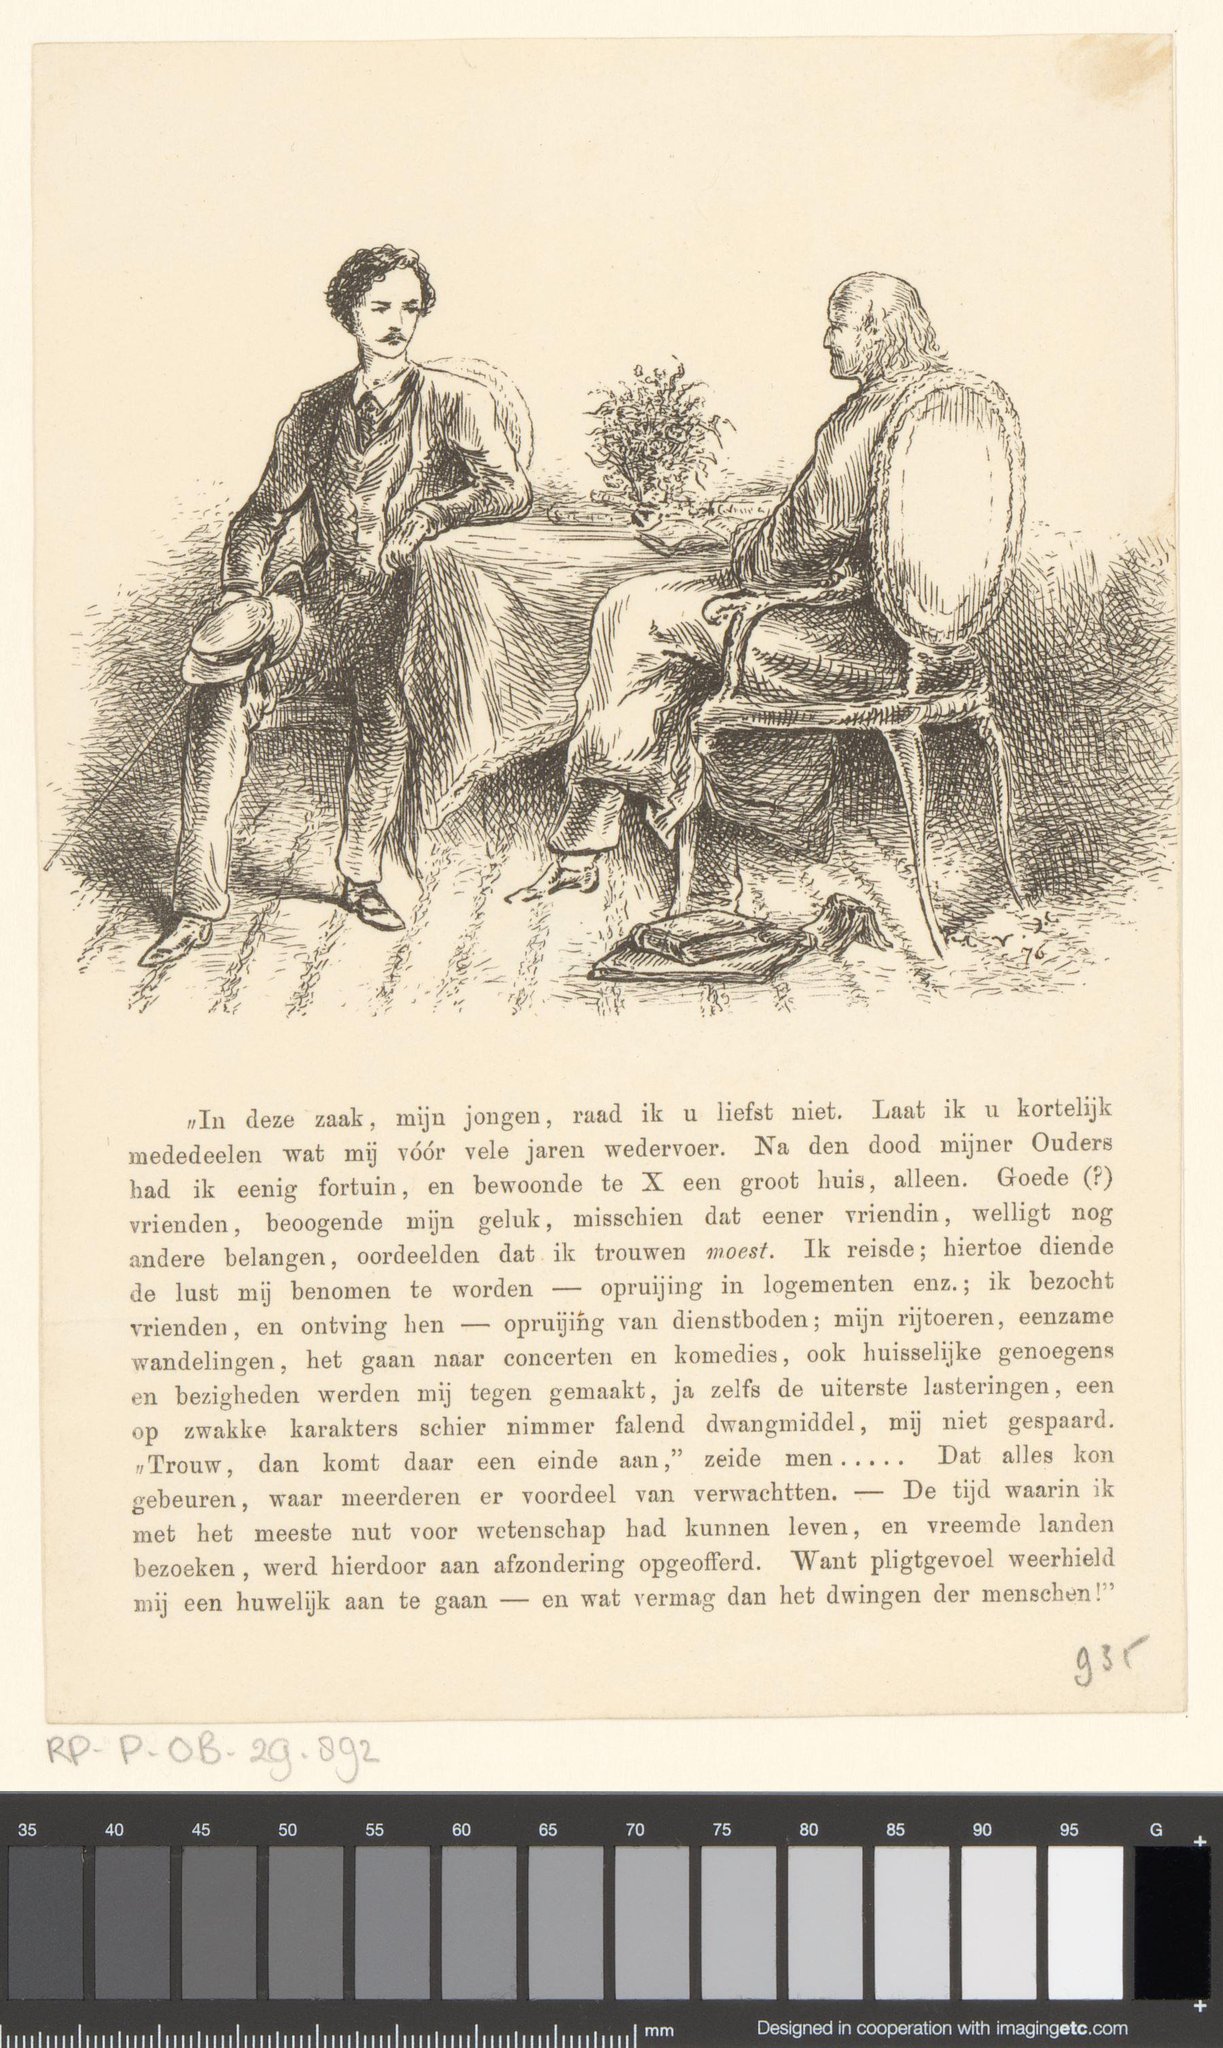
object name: print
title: Vader en zoon in gesprek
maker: alexander ver huell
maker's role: draughtsman, print maker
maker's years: 1822-1897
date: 1876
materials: paper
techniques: lithograph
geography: netherlands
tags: father and son(s) (family group), conversation, dialogue; conversation piece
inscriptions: collector's mark: Lugt 2228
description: Vader en zoon zitten aan tafel. Vader geeft de jongeman goede raad.